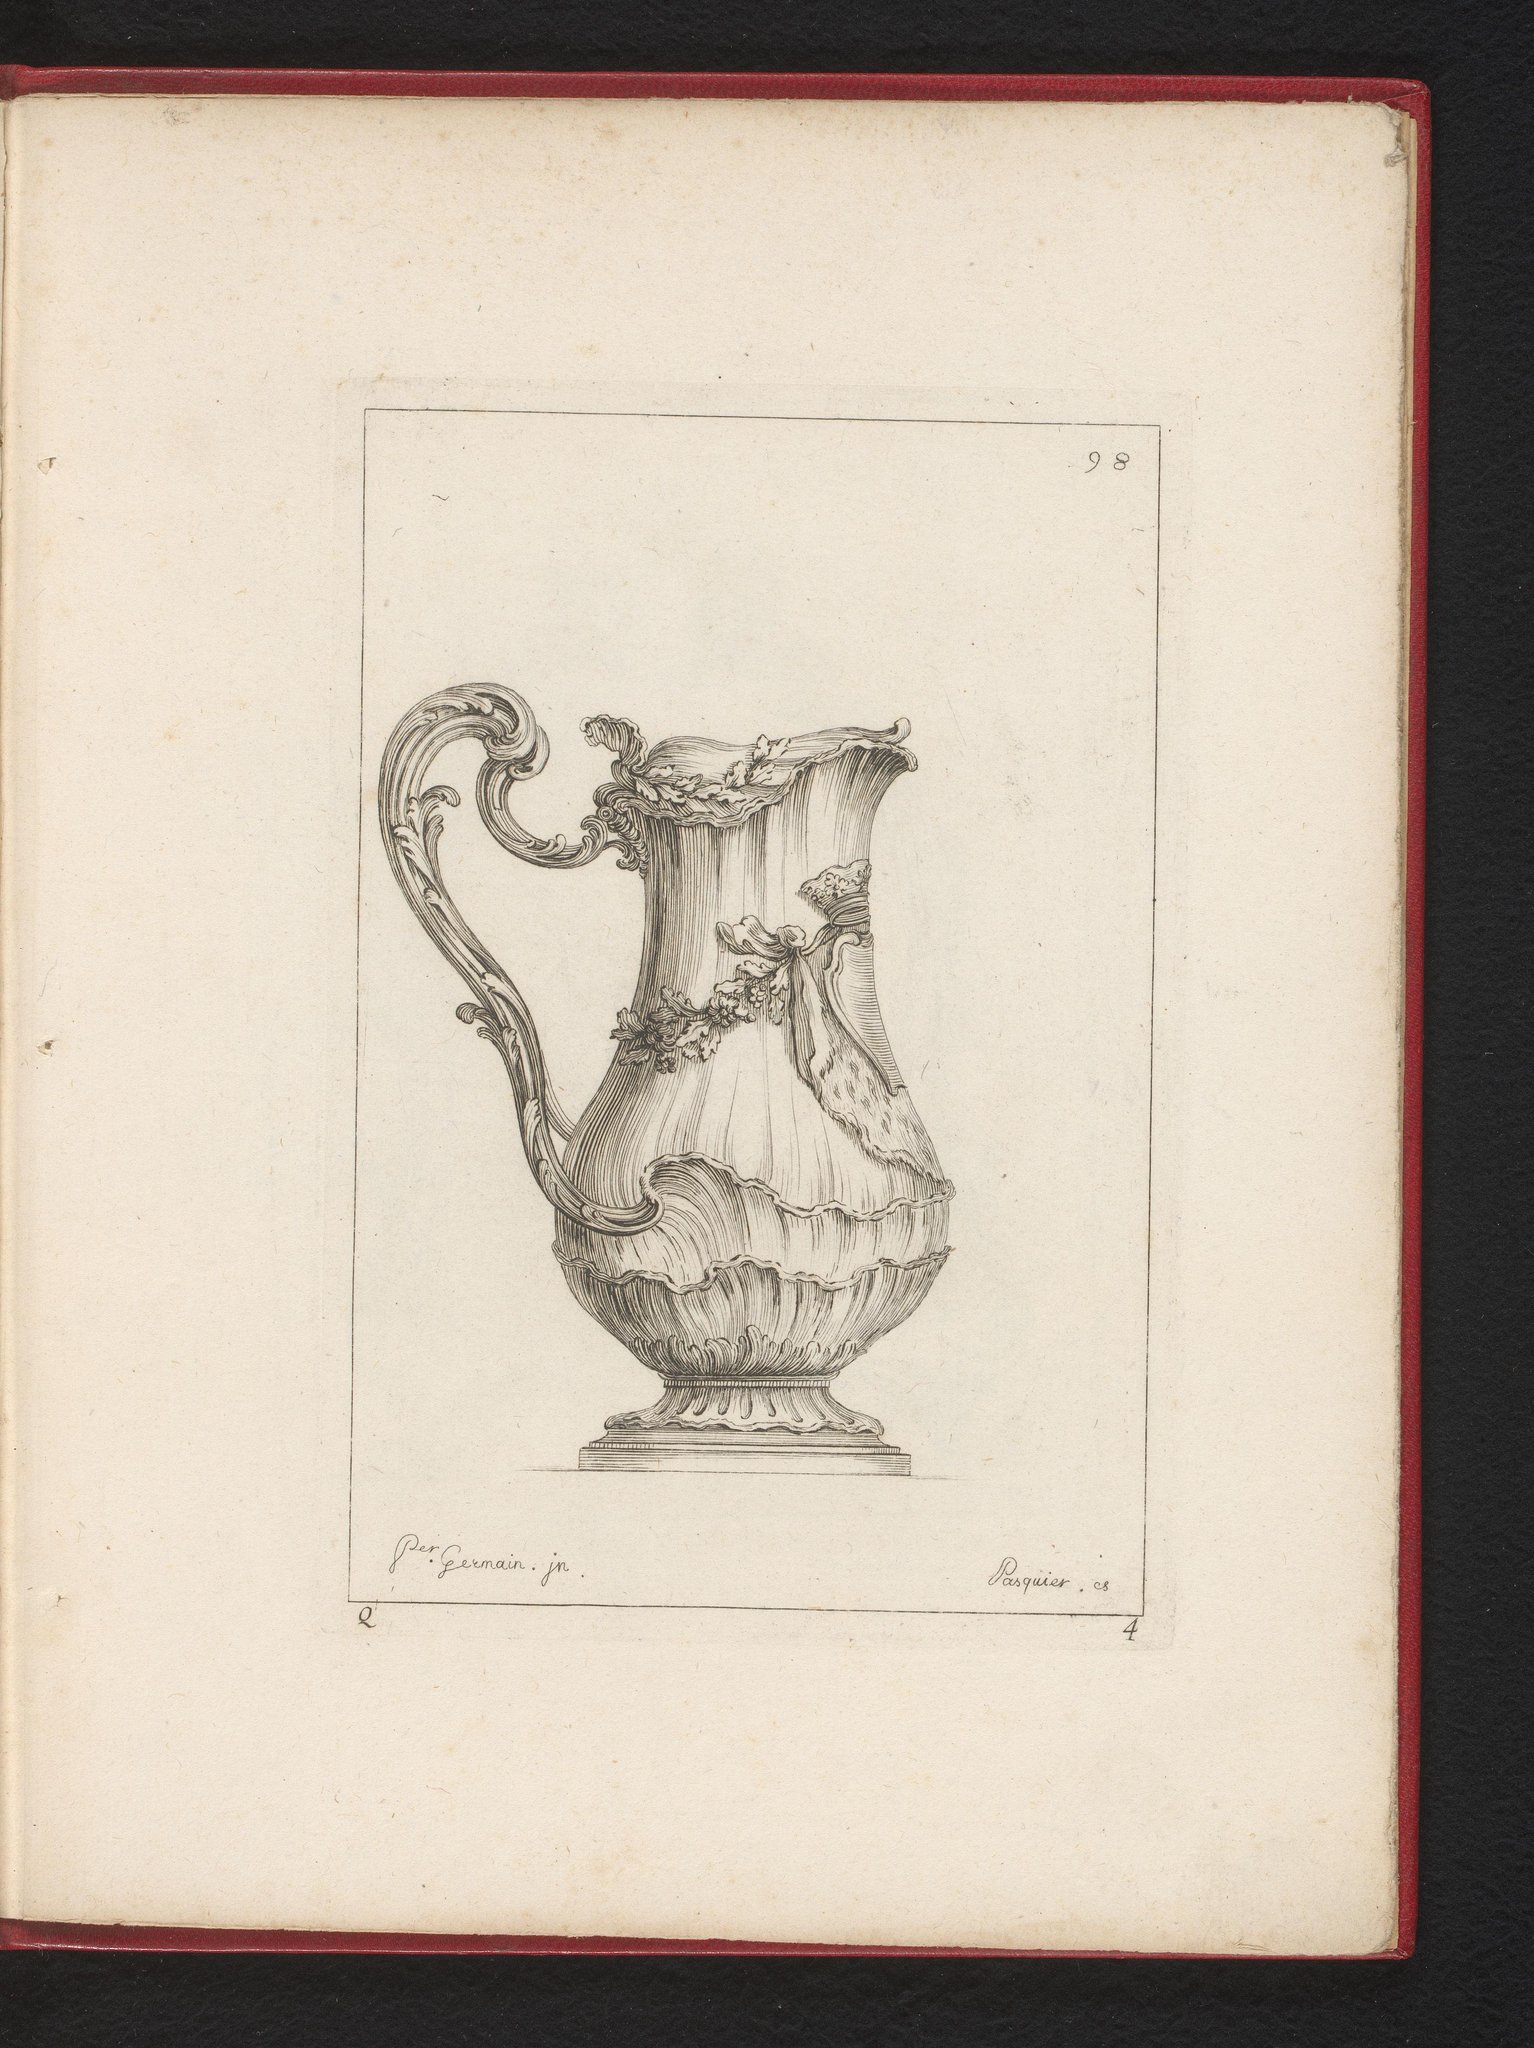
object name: print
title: Ontwerp voor een waterkan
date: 1748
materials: paper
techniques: etching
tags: jeweller, goldsmith, silversmith, container of precious metal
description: Een aantal van de objecten in deze reeks heeft een eigen ondertitel, die verwijst naar genummerde 'cahiers' (afleveringen) waarin de prenten werden uitgegeven. Het is onduidelijk welke objecten recies bij welke aflevering horen. Daarom is die ondertitel enkel verwerkt bij de prent waarop die voorkomt.